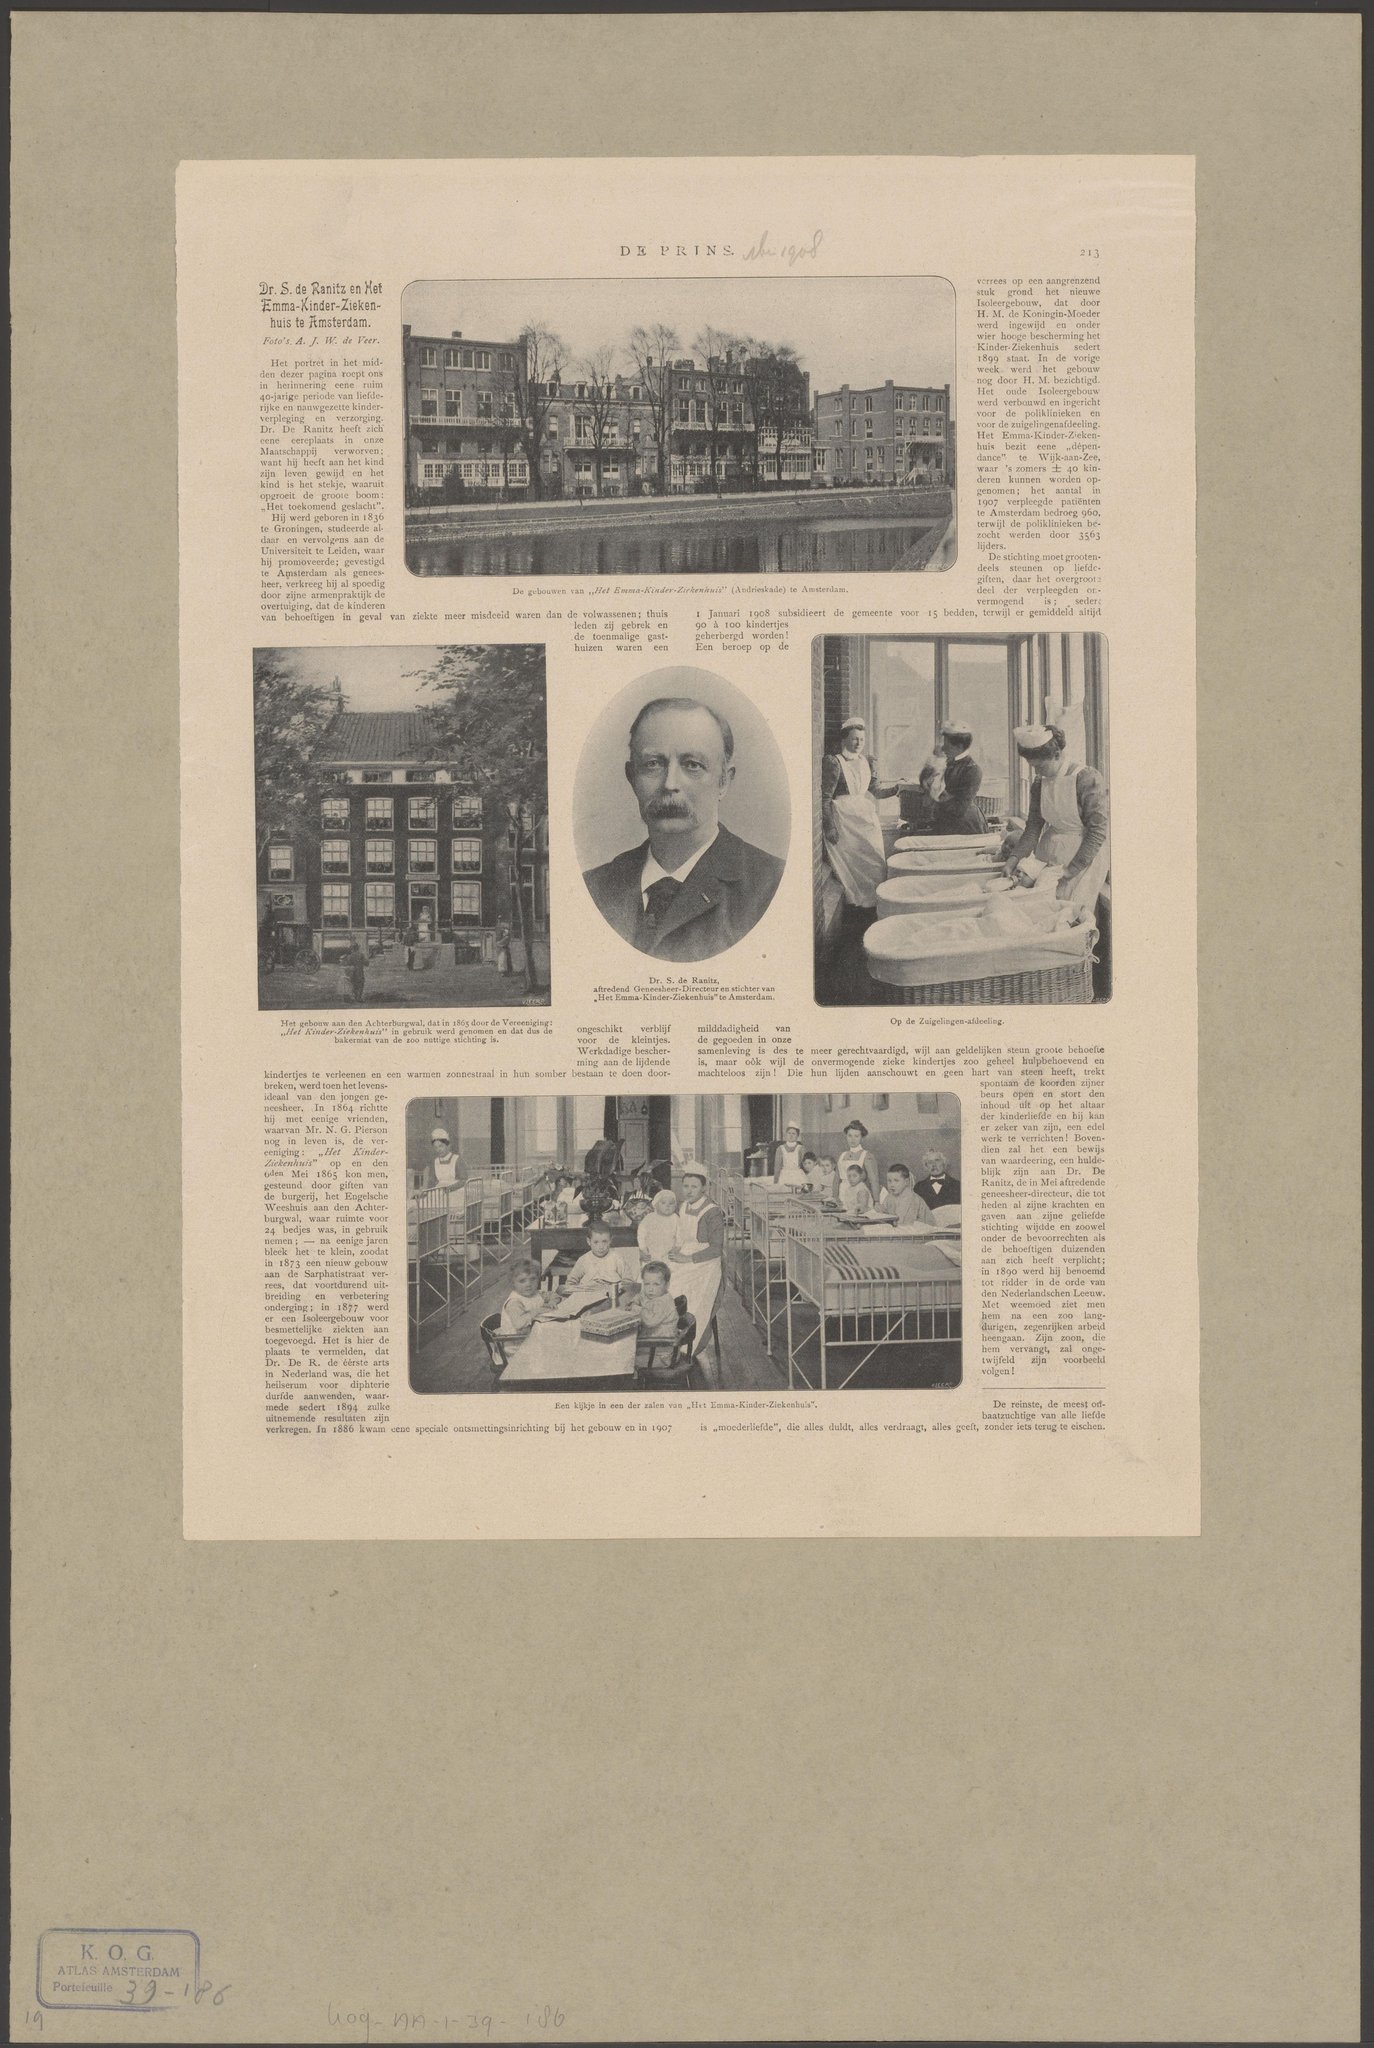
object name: photomechanical print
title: Dr. S. de Ranitz en Het Emma-Kinder-Ziekenhuis te Amsterdam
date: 1905-1908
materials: paper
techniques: letterpress printing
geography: amsterdam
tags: nurse ~ hospital, historical persons, physician, doctor, hospital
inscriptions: collector's mark: Lugt 1641b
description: Onderwerpsrubriek binnen de Atlas Amsterdam: Armwezen en liefdadige instellingen: V. Ziekenhuizen: Kinderziekenhuis Sarphatistraat - Luth. Diaconessen Inrichting.